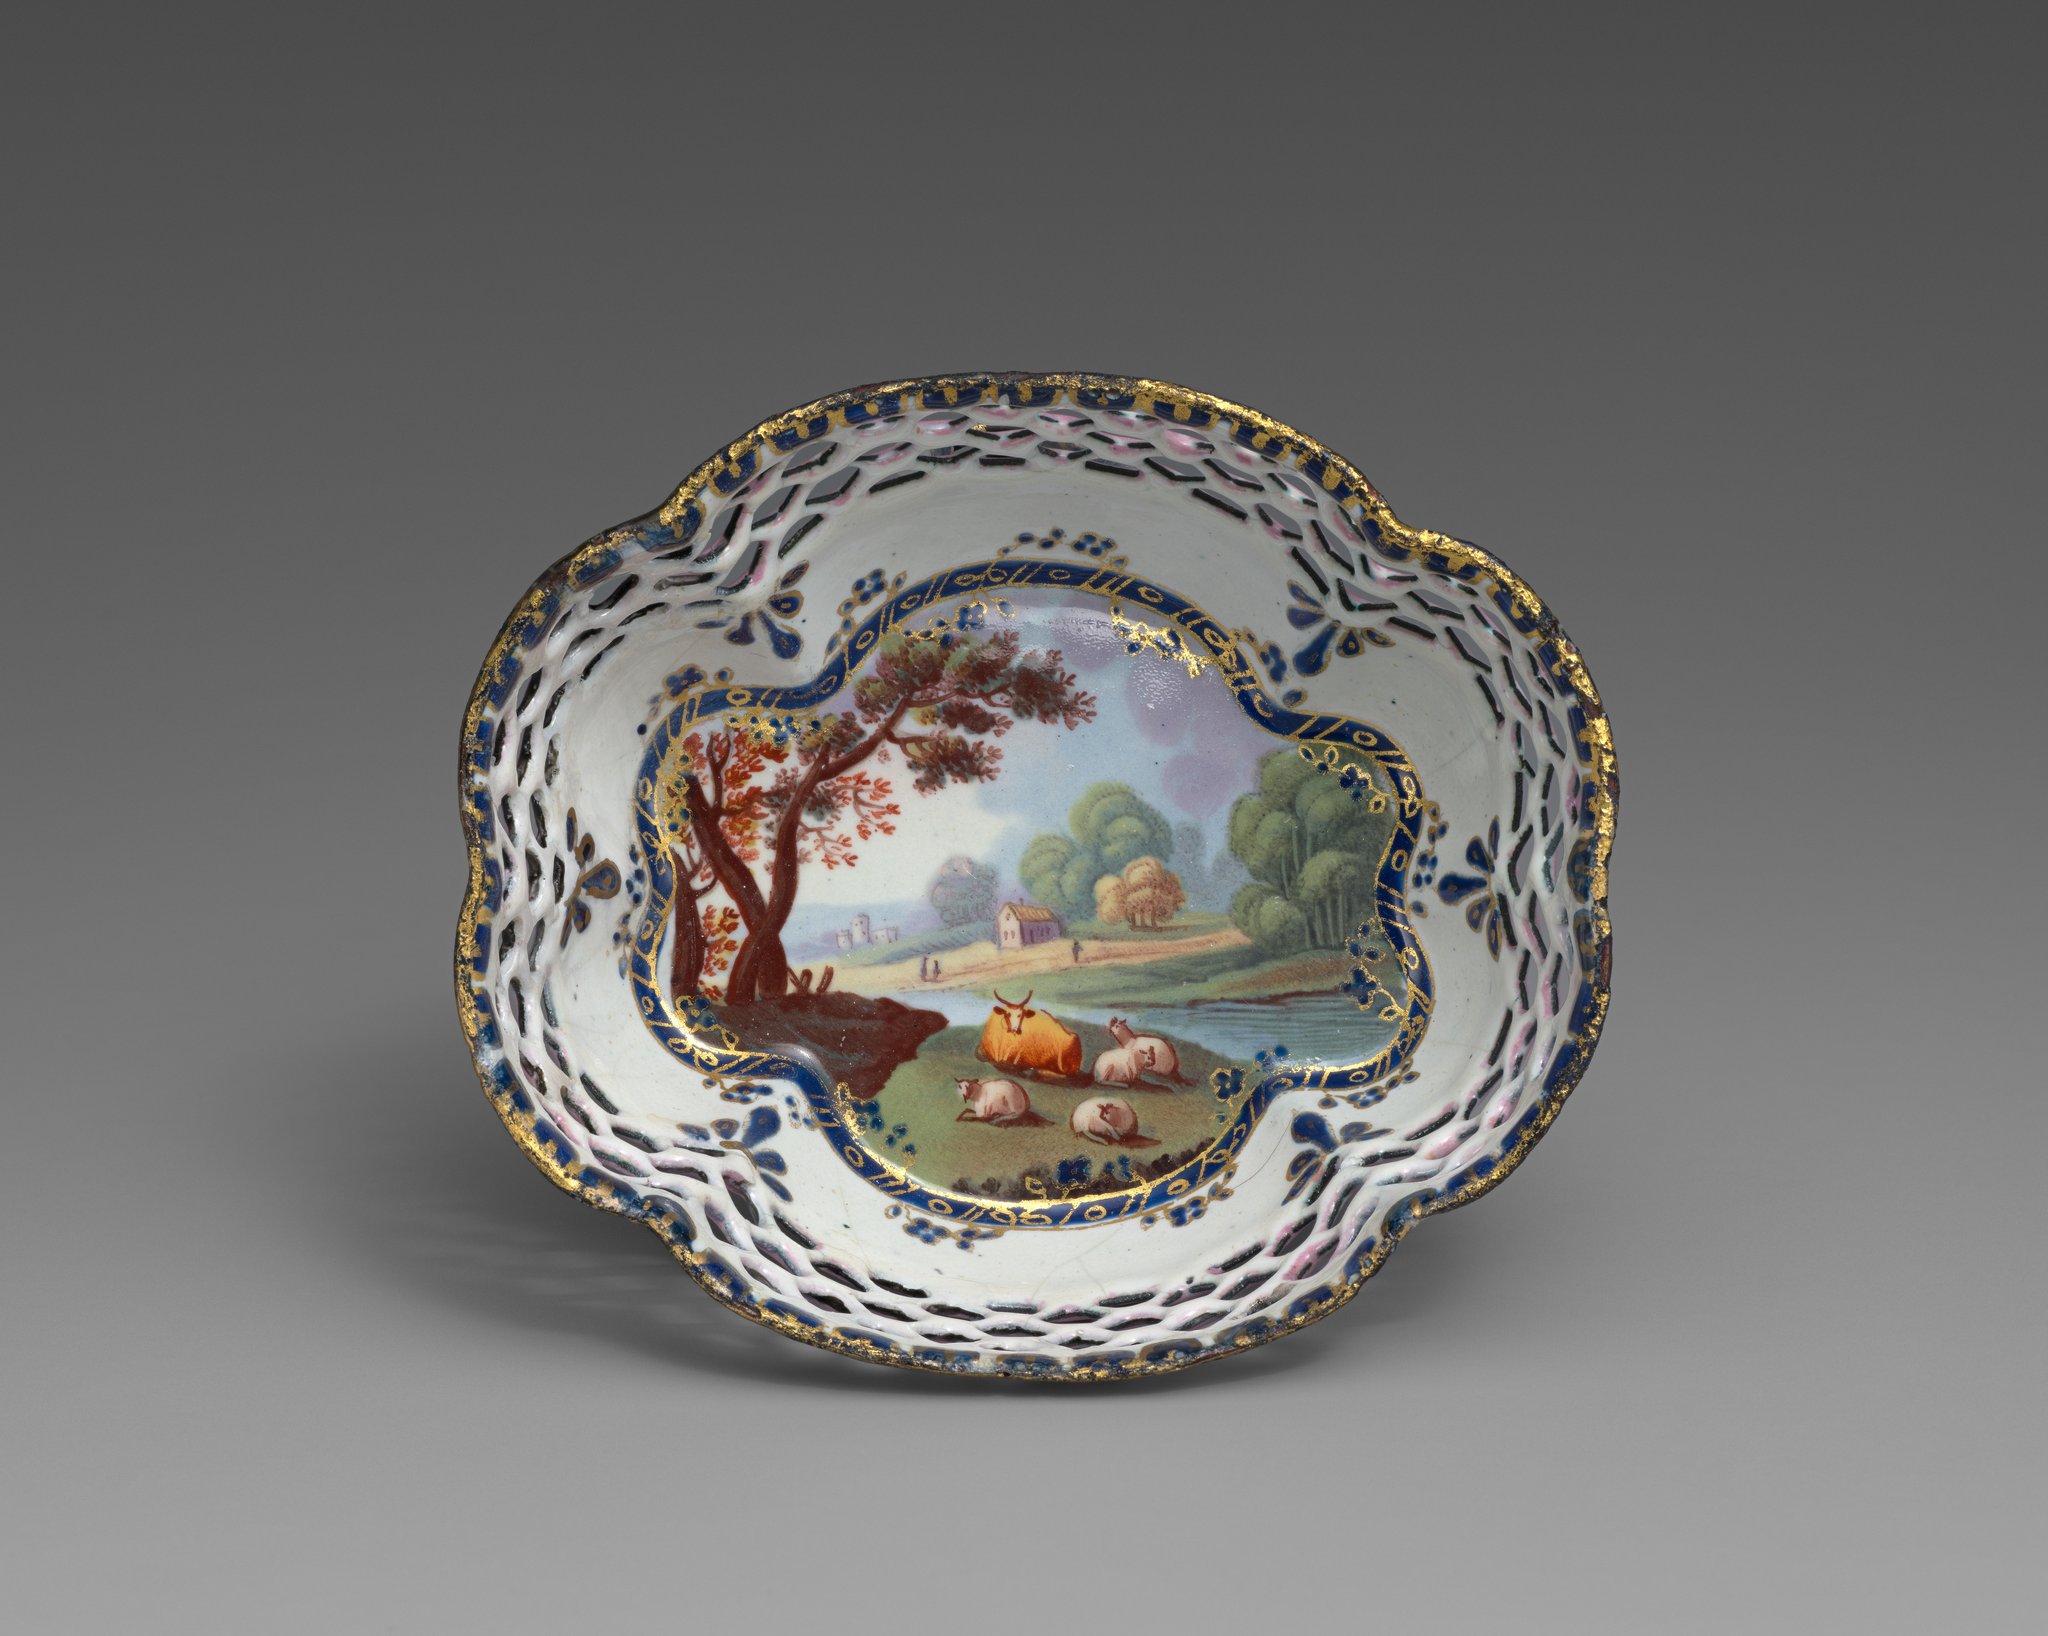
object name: counter tray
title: Set of four counter trays for the card game of Quadrille (part of a set)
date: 1770-1775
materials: copper, enamel